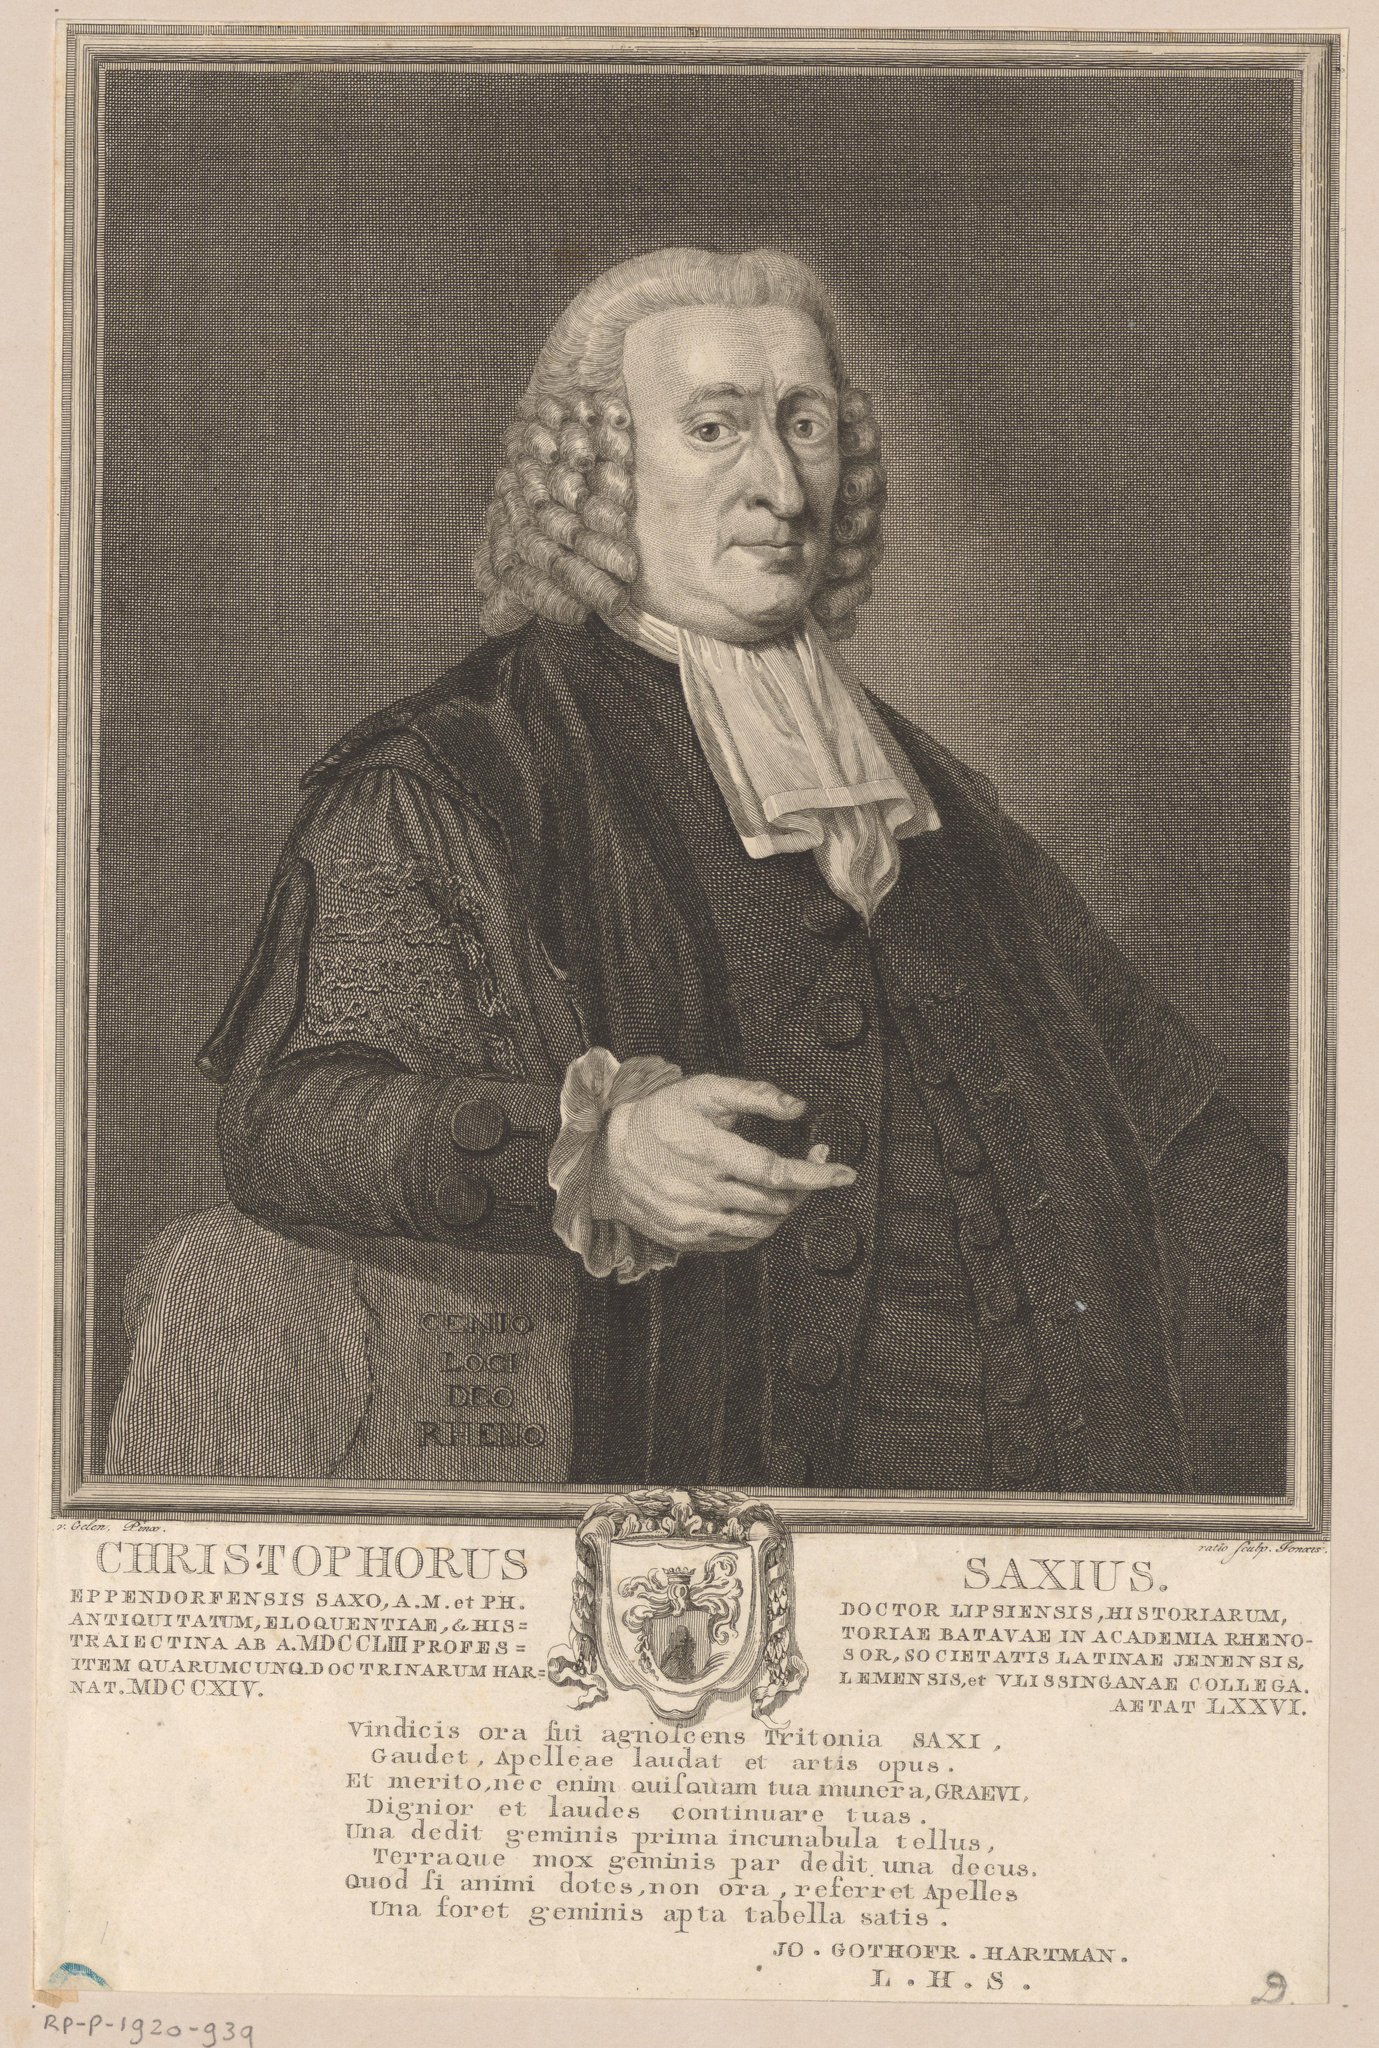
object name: print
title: Portret van Christophorus Saxius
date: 1790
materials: paper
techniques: engraving, etching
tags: historical persons, professor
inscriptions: inscription: ‘D’, collector's mark: Lugt 2228